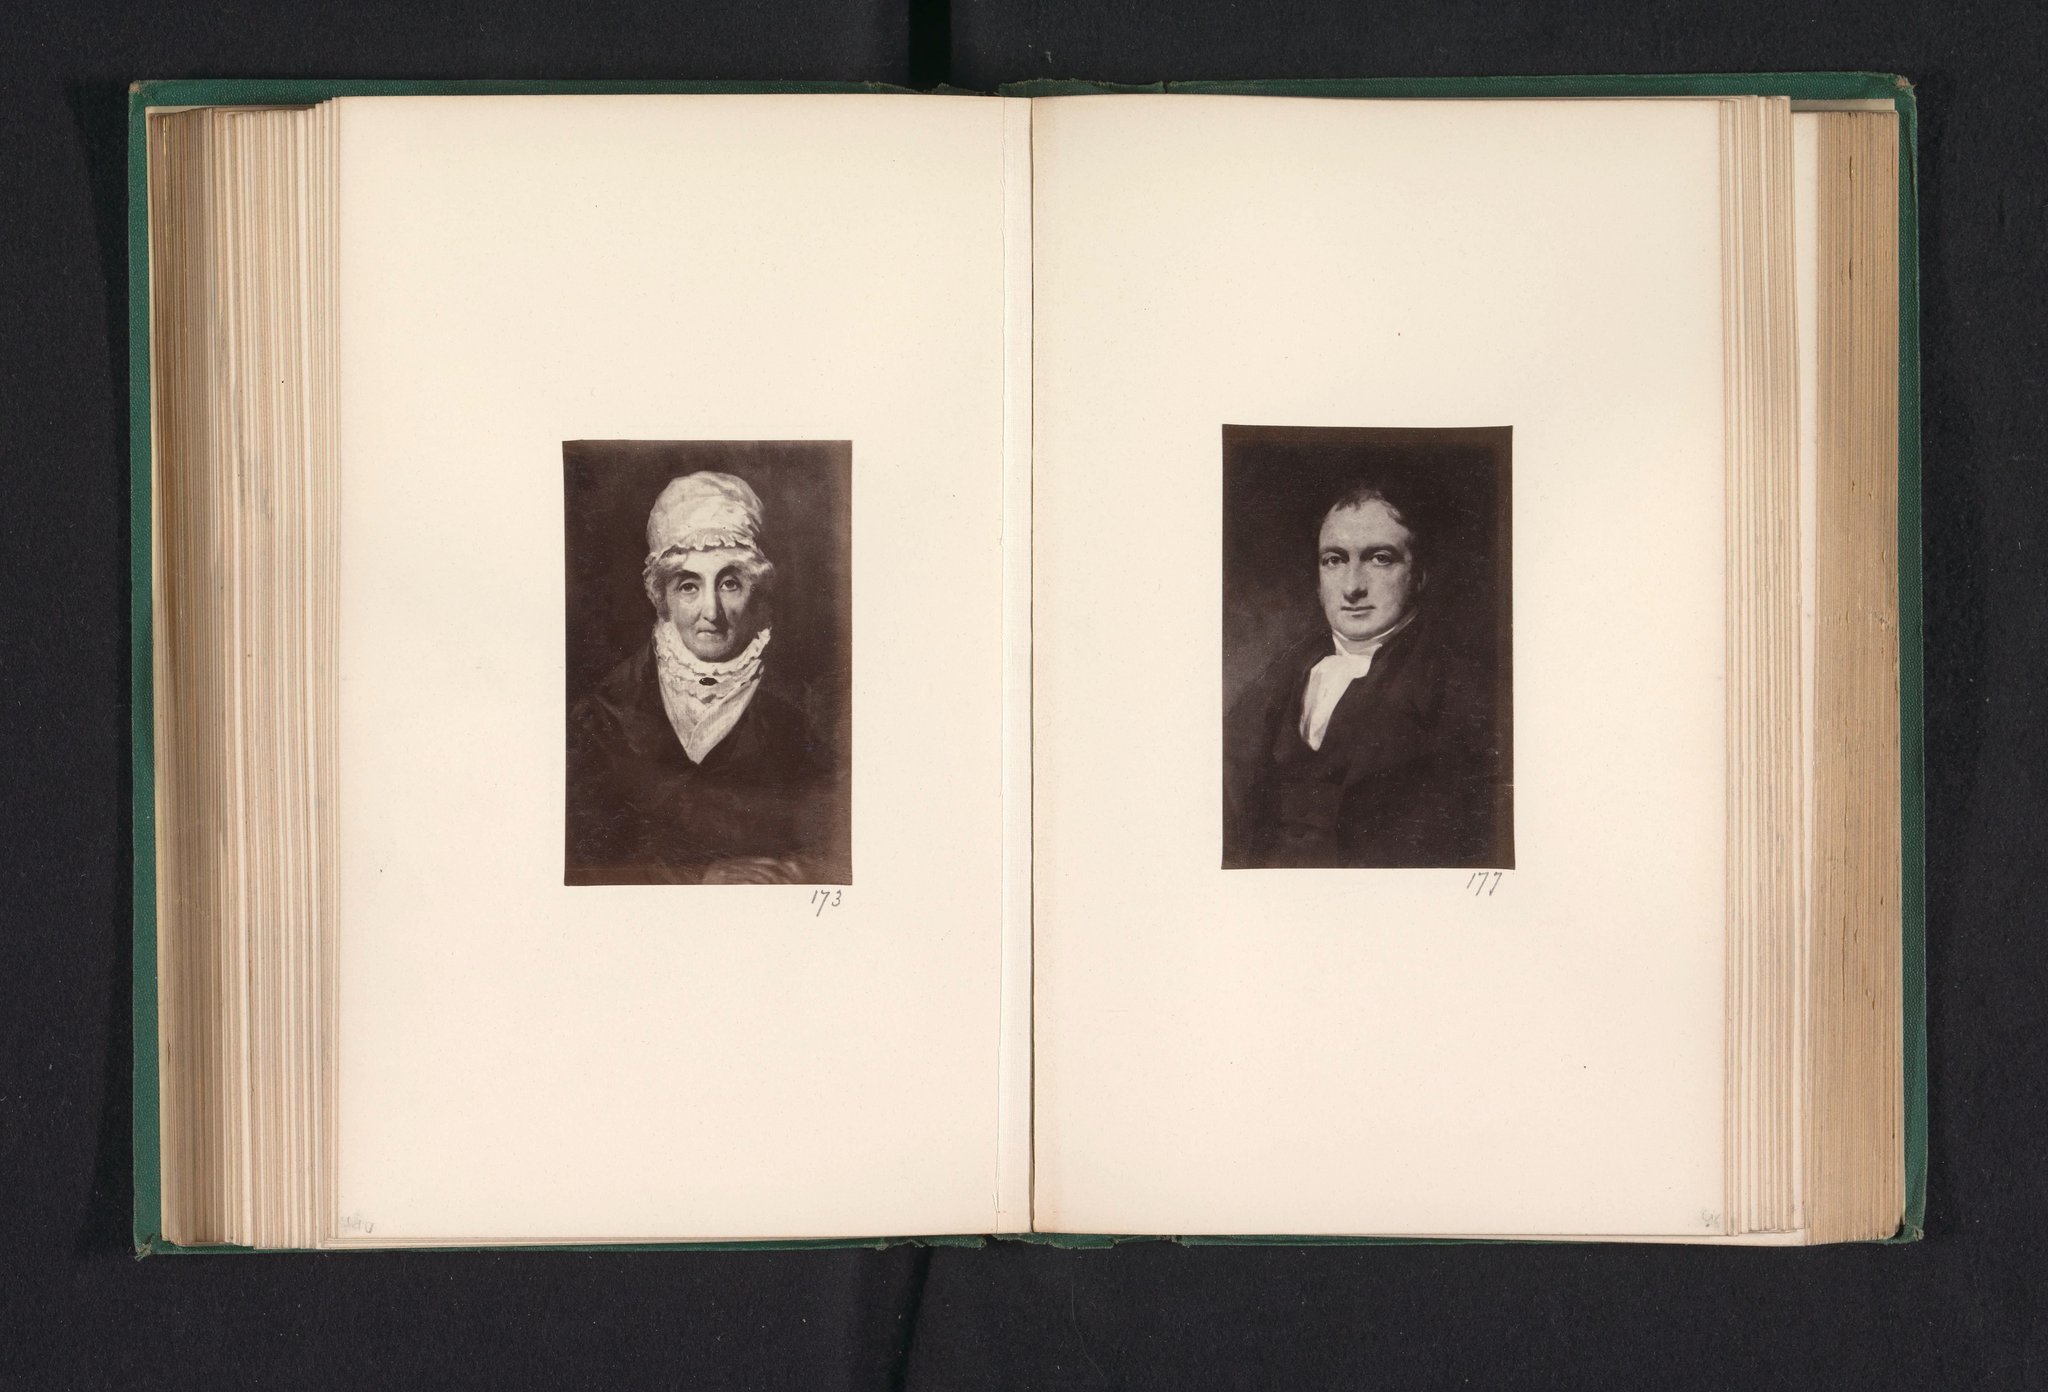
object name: reproduction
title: Fotoreproductie van een schilderij, voorstellende een portret van Mary Buchanan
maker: thomas annan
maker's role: fotograaf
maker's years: 1829-1887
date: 1863-1868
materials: photographic support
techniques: albumen print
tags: historical persons (portraits and scenes from the life) (+ (full) bust portrait)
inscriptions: number: ‘173’